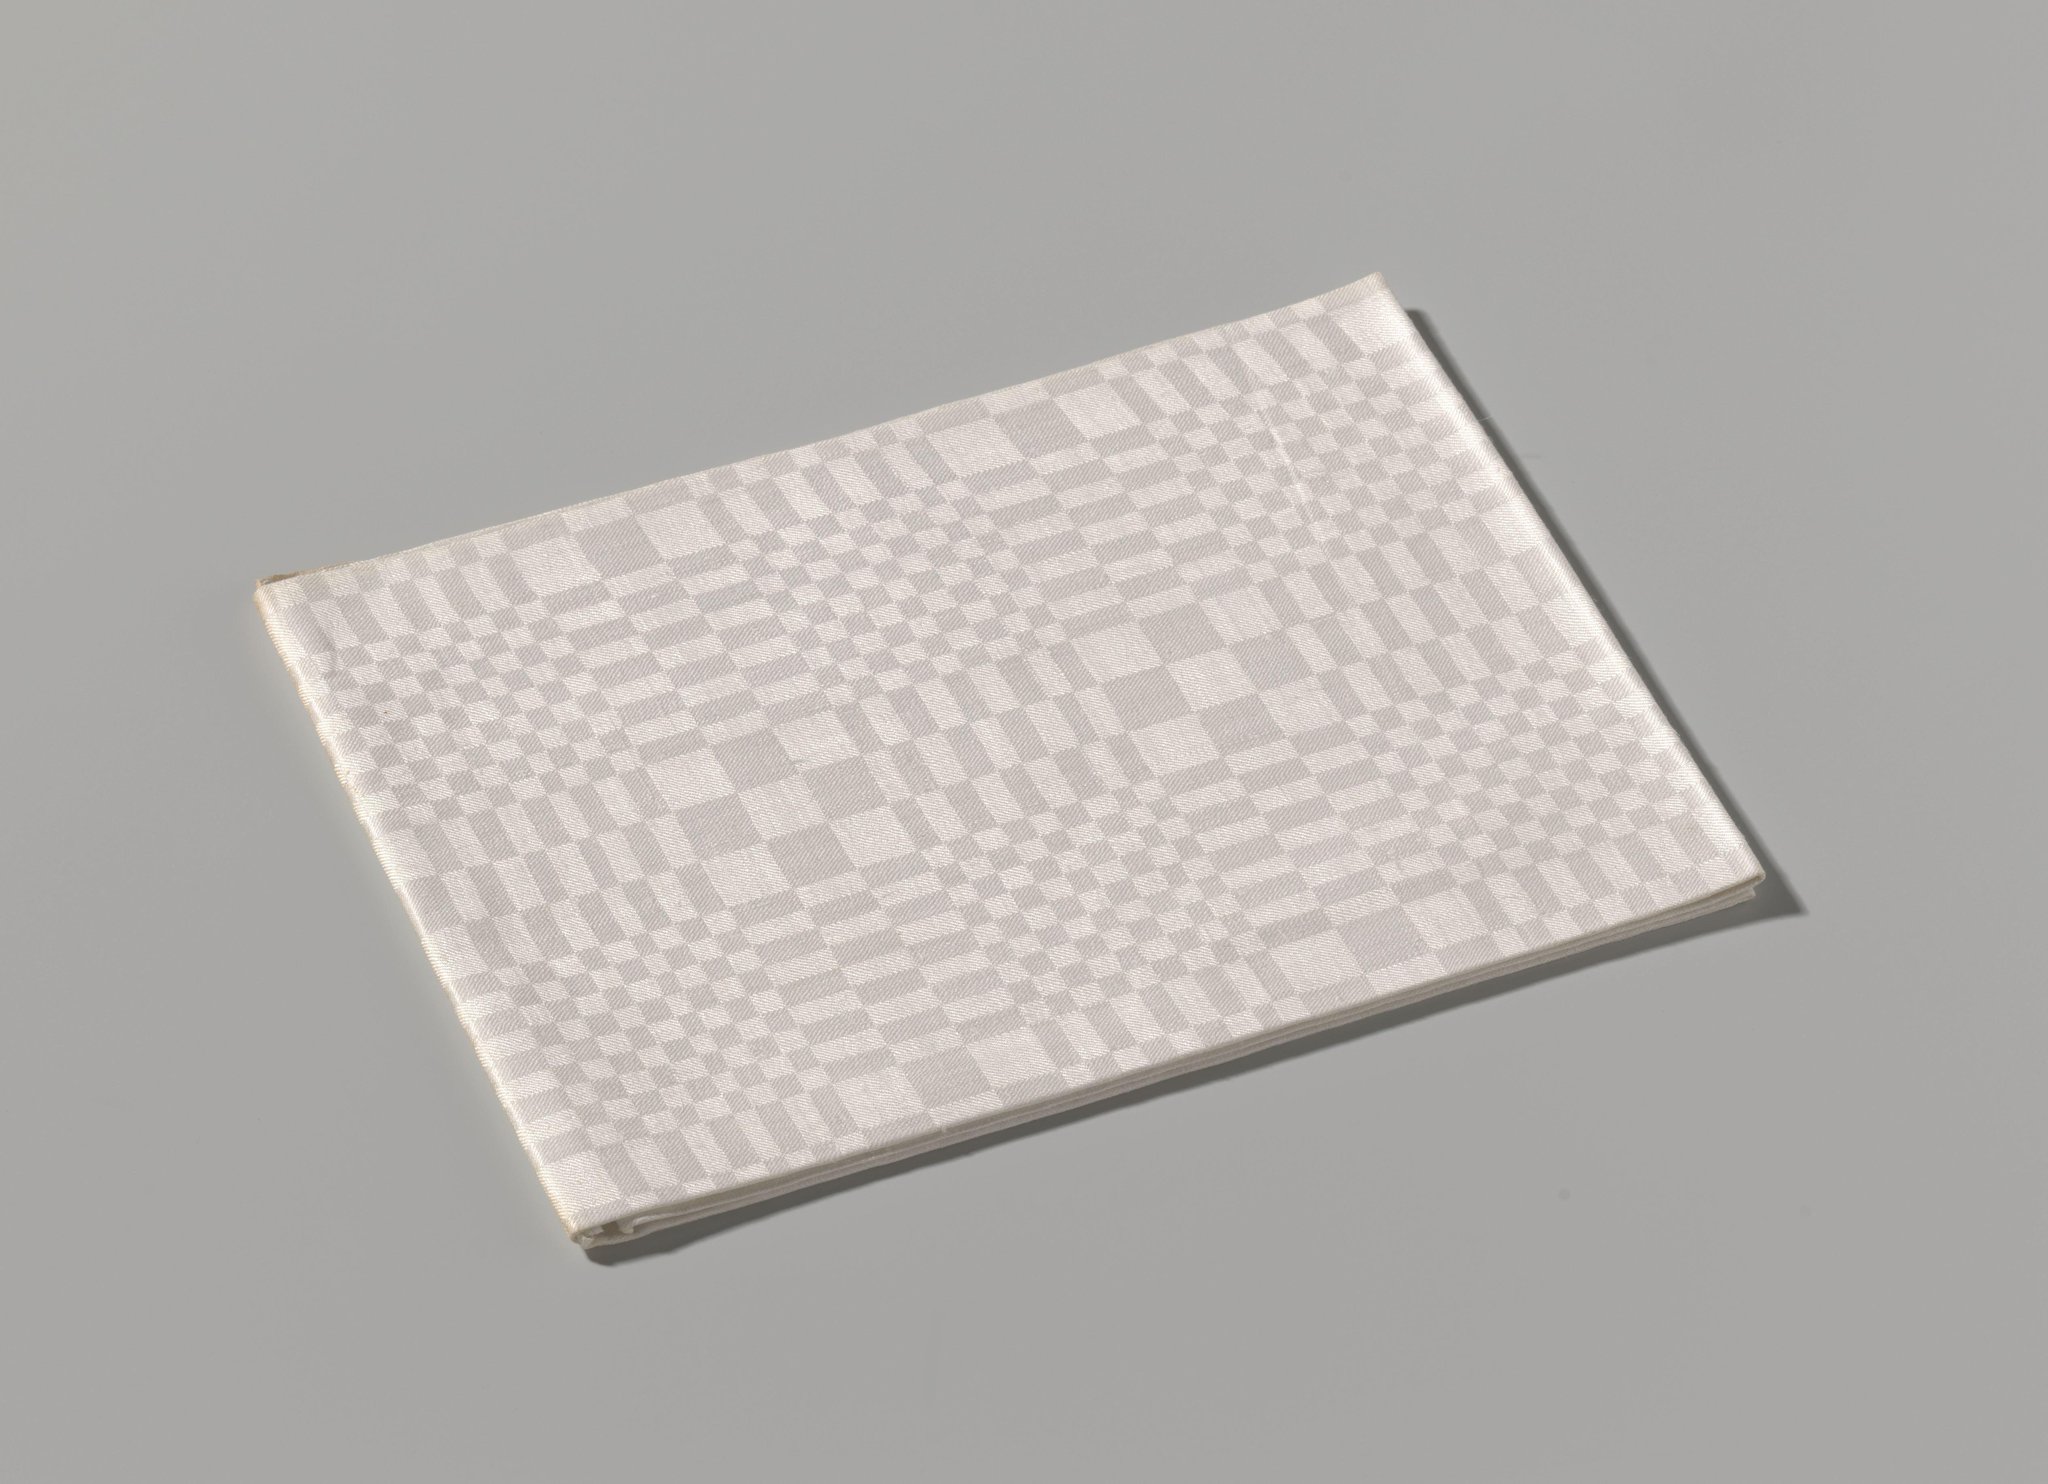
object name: napkin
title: Servet van pellendamast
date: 1739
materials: linen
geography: northern netherlands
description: Wit linnen servet met pellenpatroon, genaamd "Engelse garderobe". Merk kroon WG 36 1739.